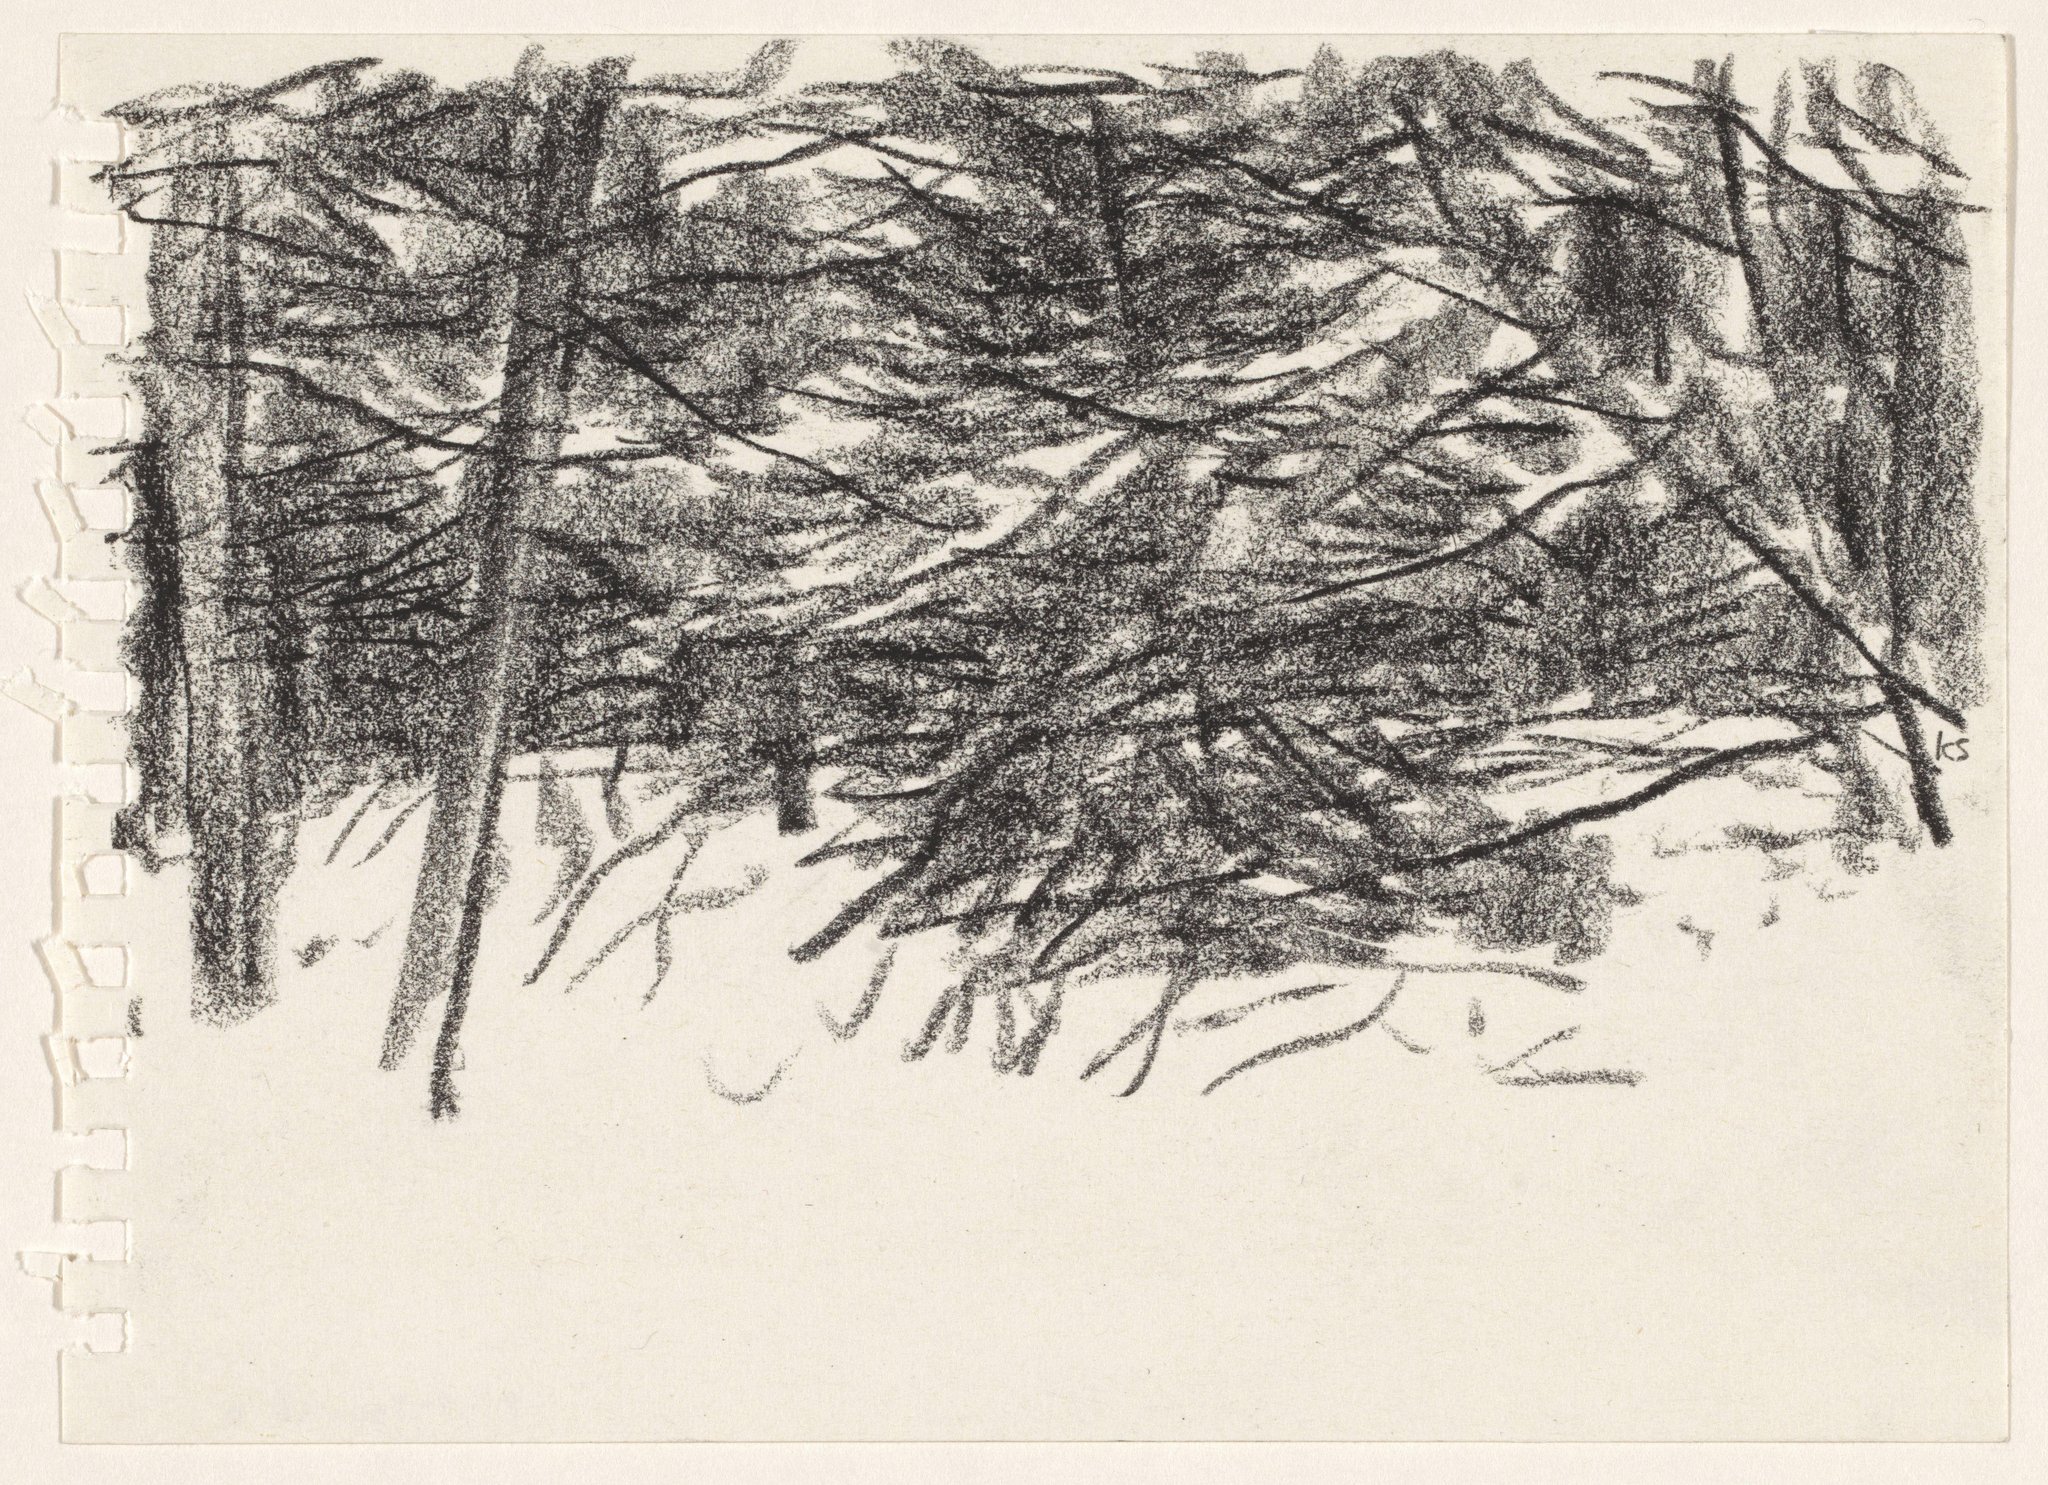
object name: drawing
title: Bomen en struikgewas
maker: kees stoop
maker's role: draughtsman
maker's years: 1929-2019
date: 1939-2009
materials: charcoal, paper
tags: trees